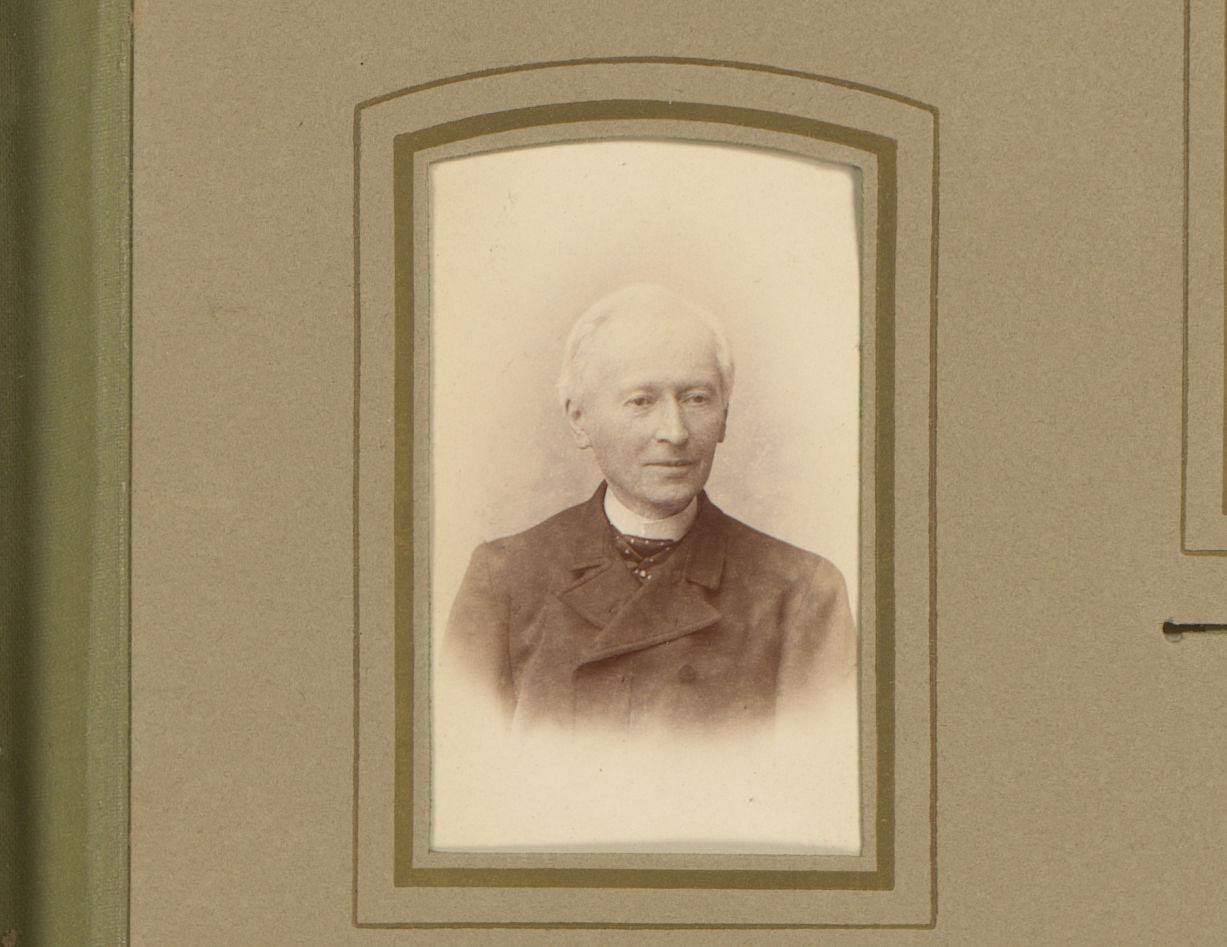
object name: carte de visite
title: Portret van een man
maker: emil tiedemann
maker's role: fotograaf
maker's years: 1858-1892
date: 1859-1892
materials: cardboard, photographic support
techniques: albumen print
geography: germany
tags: historical persons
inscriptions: inscription: ‘EMIL TIEDEMANN/ (...)/ HOF-PHOTOGRAPH/ (...)/ BREMEN/ Richtweg No 12./ (...)/ HANNOVER/ Georgstr, 13./ BRAUNSCHWEIG/ Bohlweg 66./ DESSAU/ Leopoldstr. 4./ BRAKE/ a/d. Weser.’